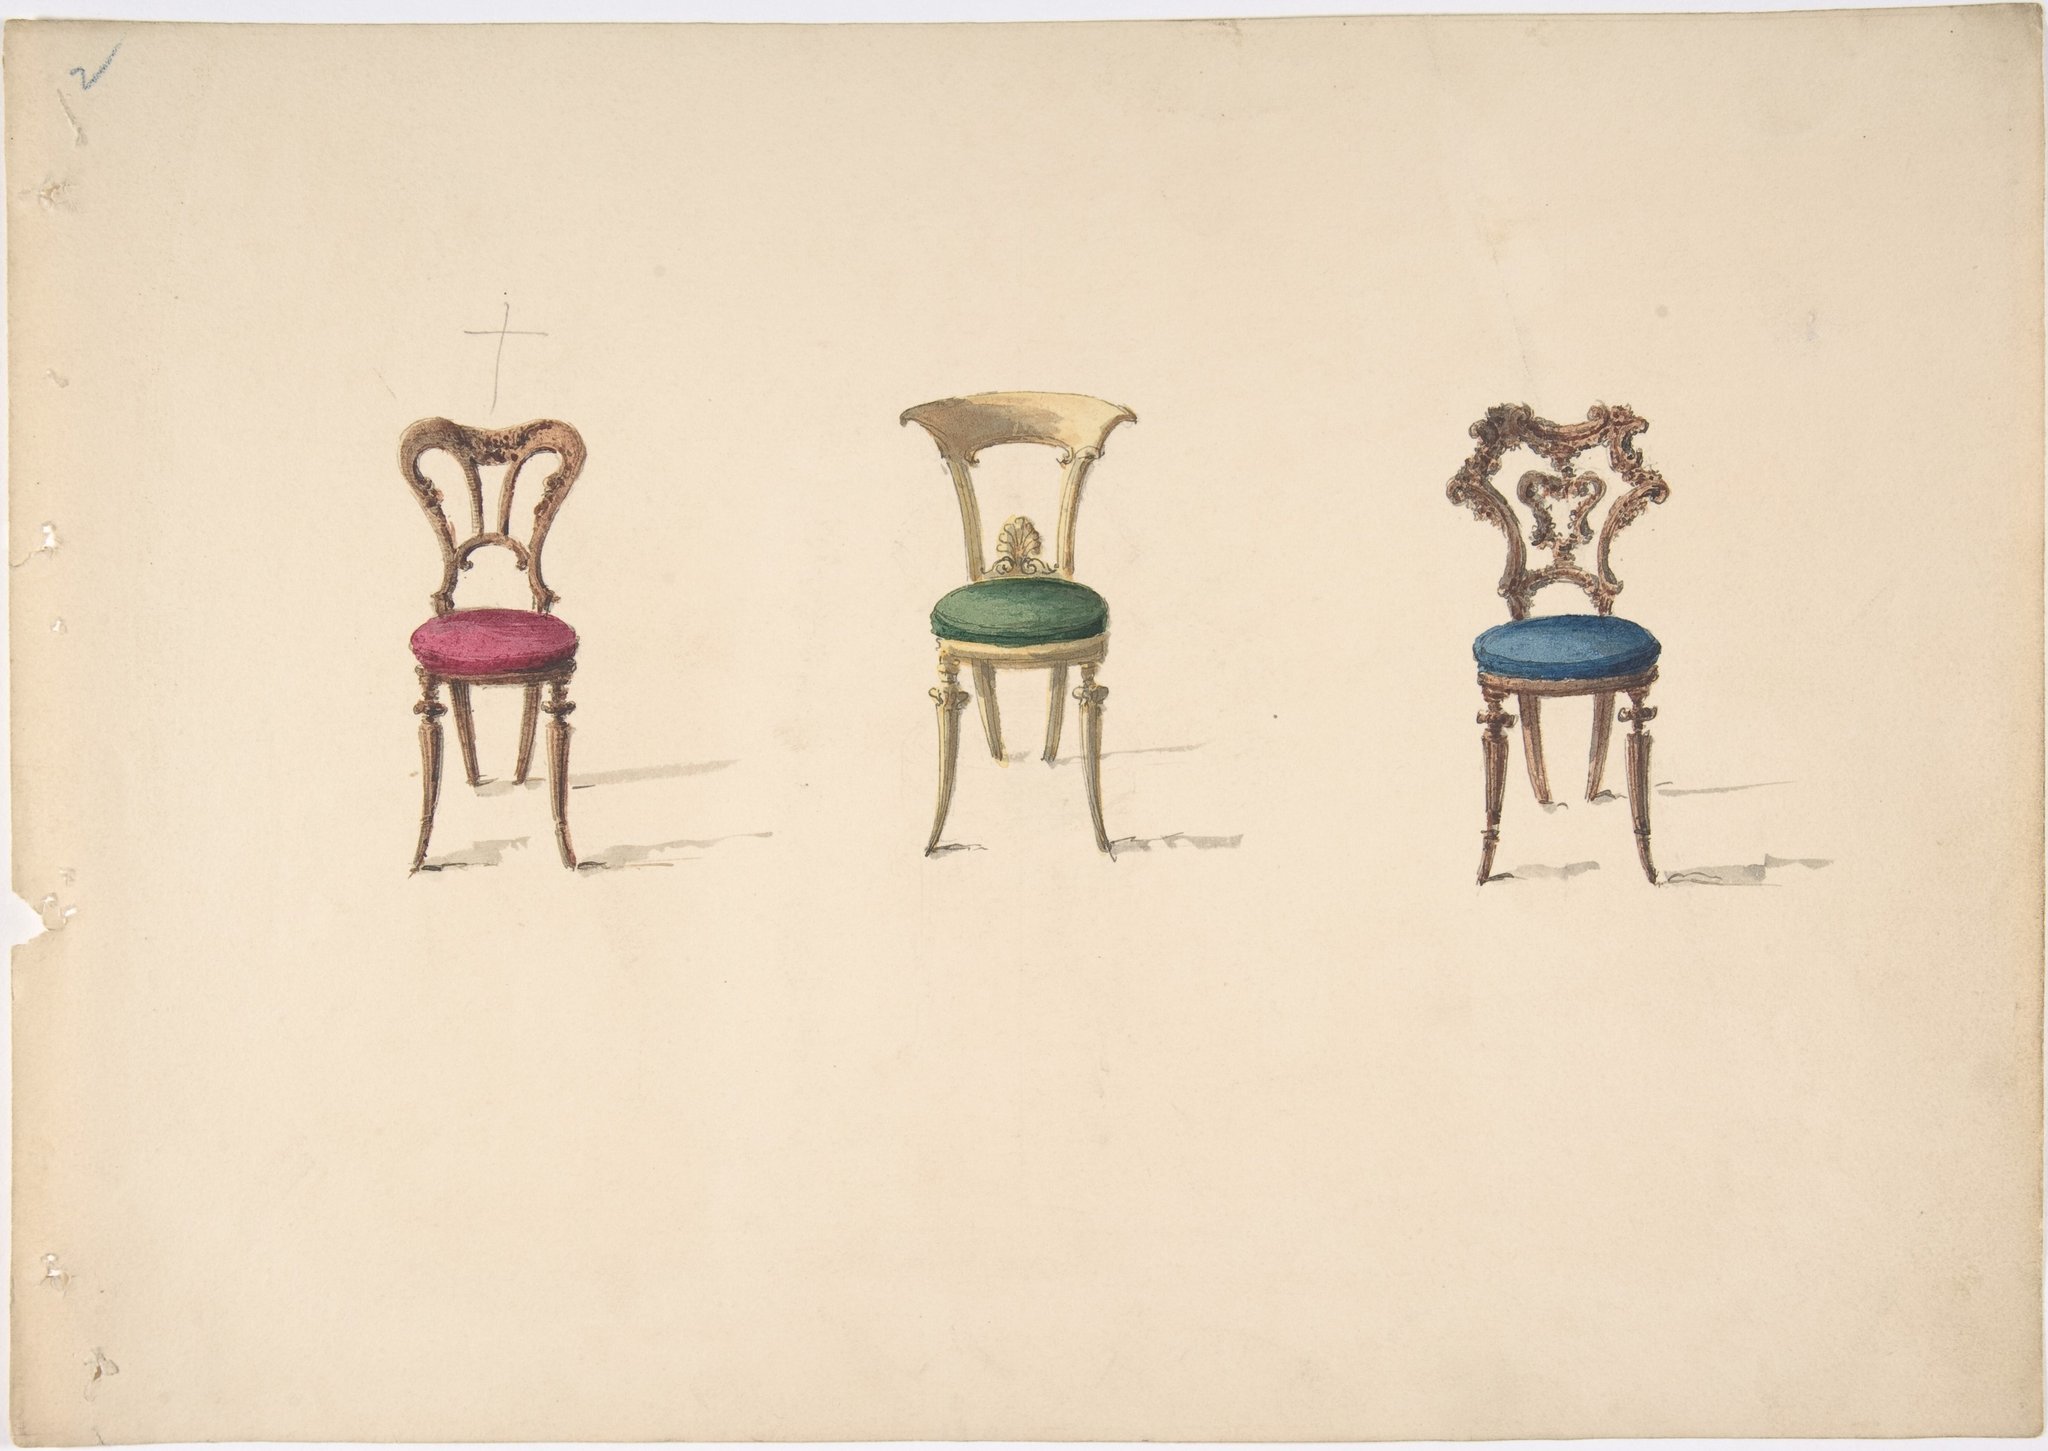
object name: drawing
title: Design for Three Chairs with Red, Green and Blue Seats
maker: anonymous, british, 19th century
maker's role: artist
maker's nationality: british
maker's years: 1800-1900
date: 1801-1833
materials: ink, watercolor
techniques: brush, pen, wash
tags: chairs